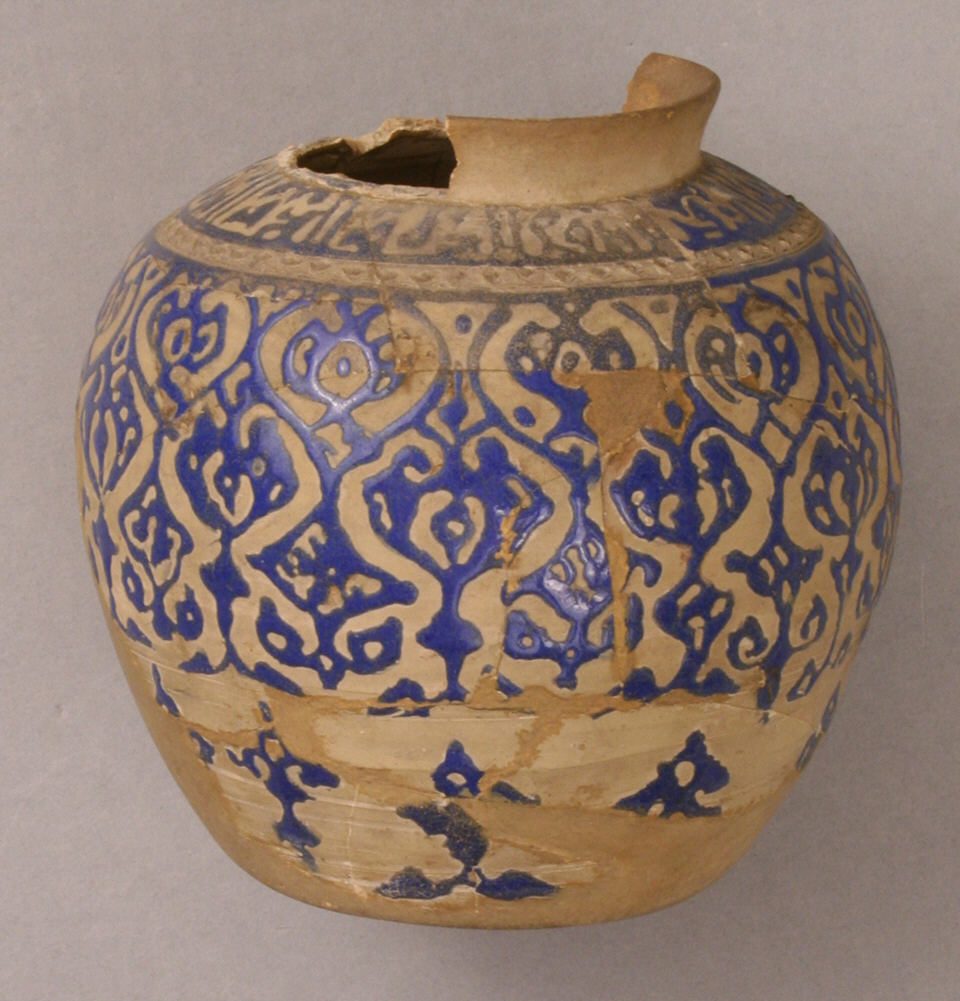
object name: jar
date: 1201-1300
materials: stonepaste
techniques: glazing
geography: iran